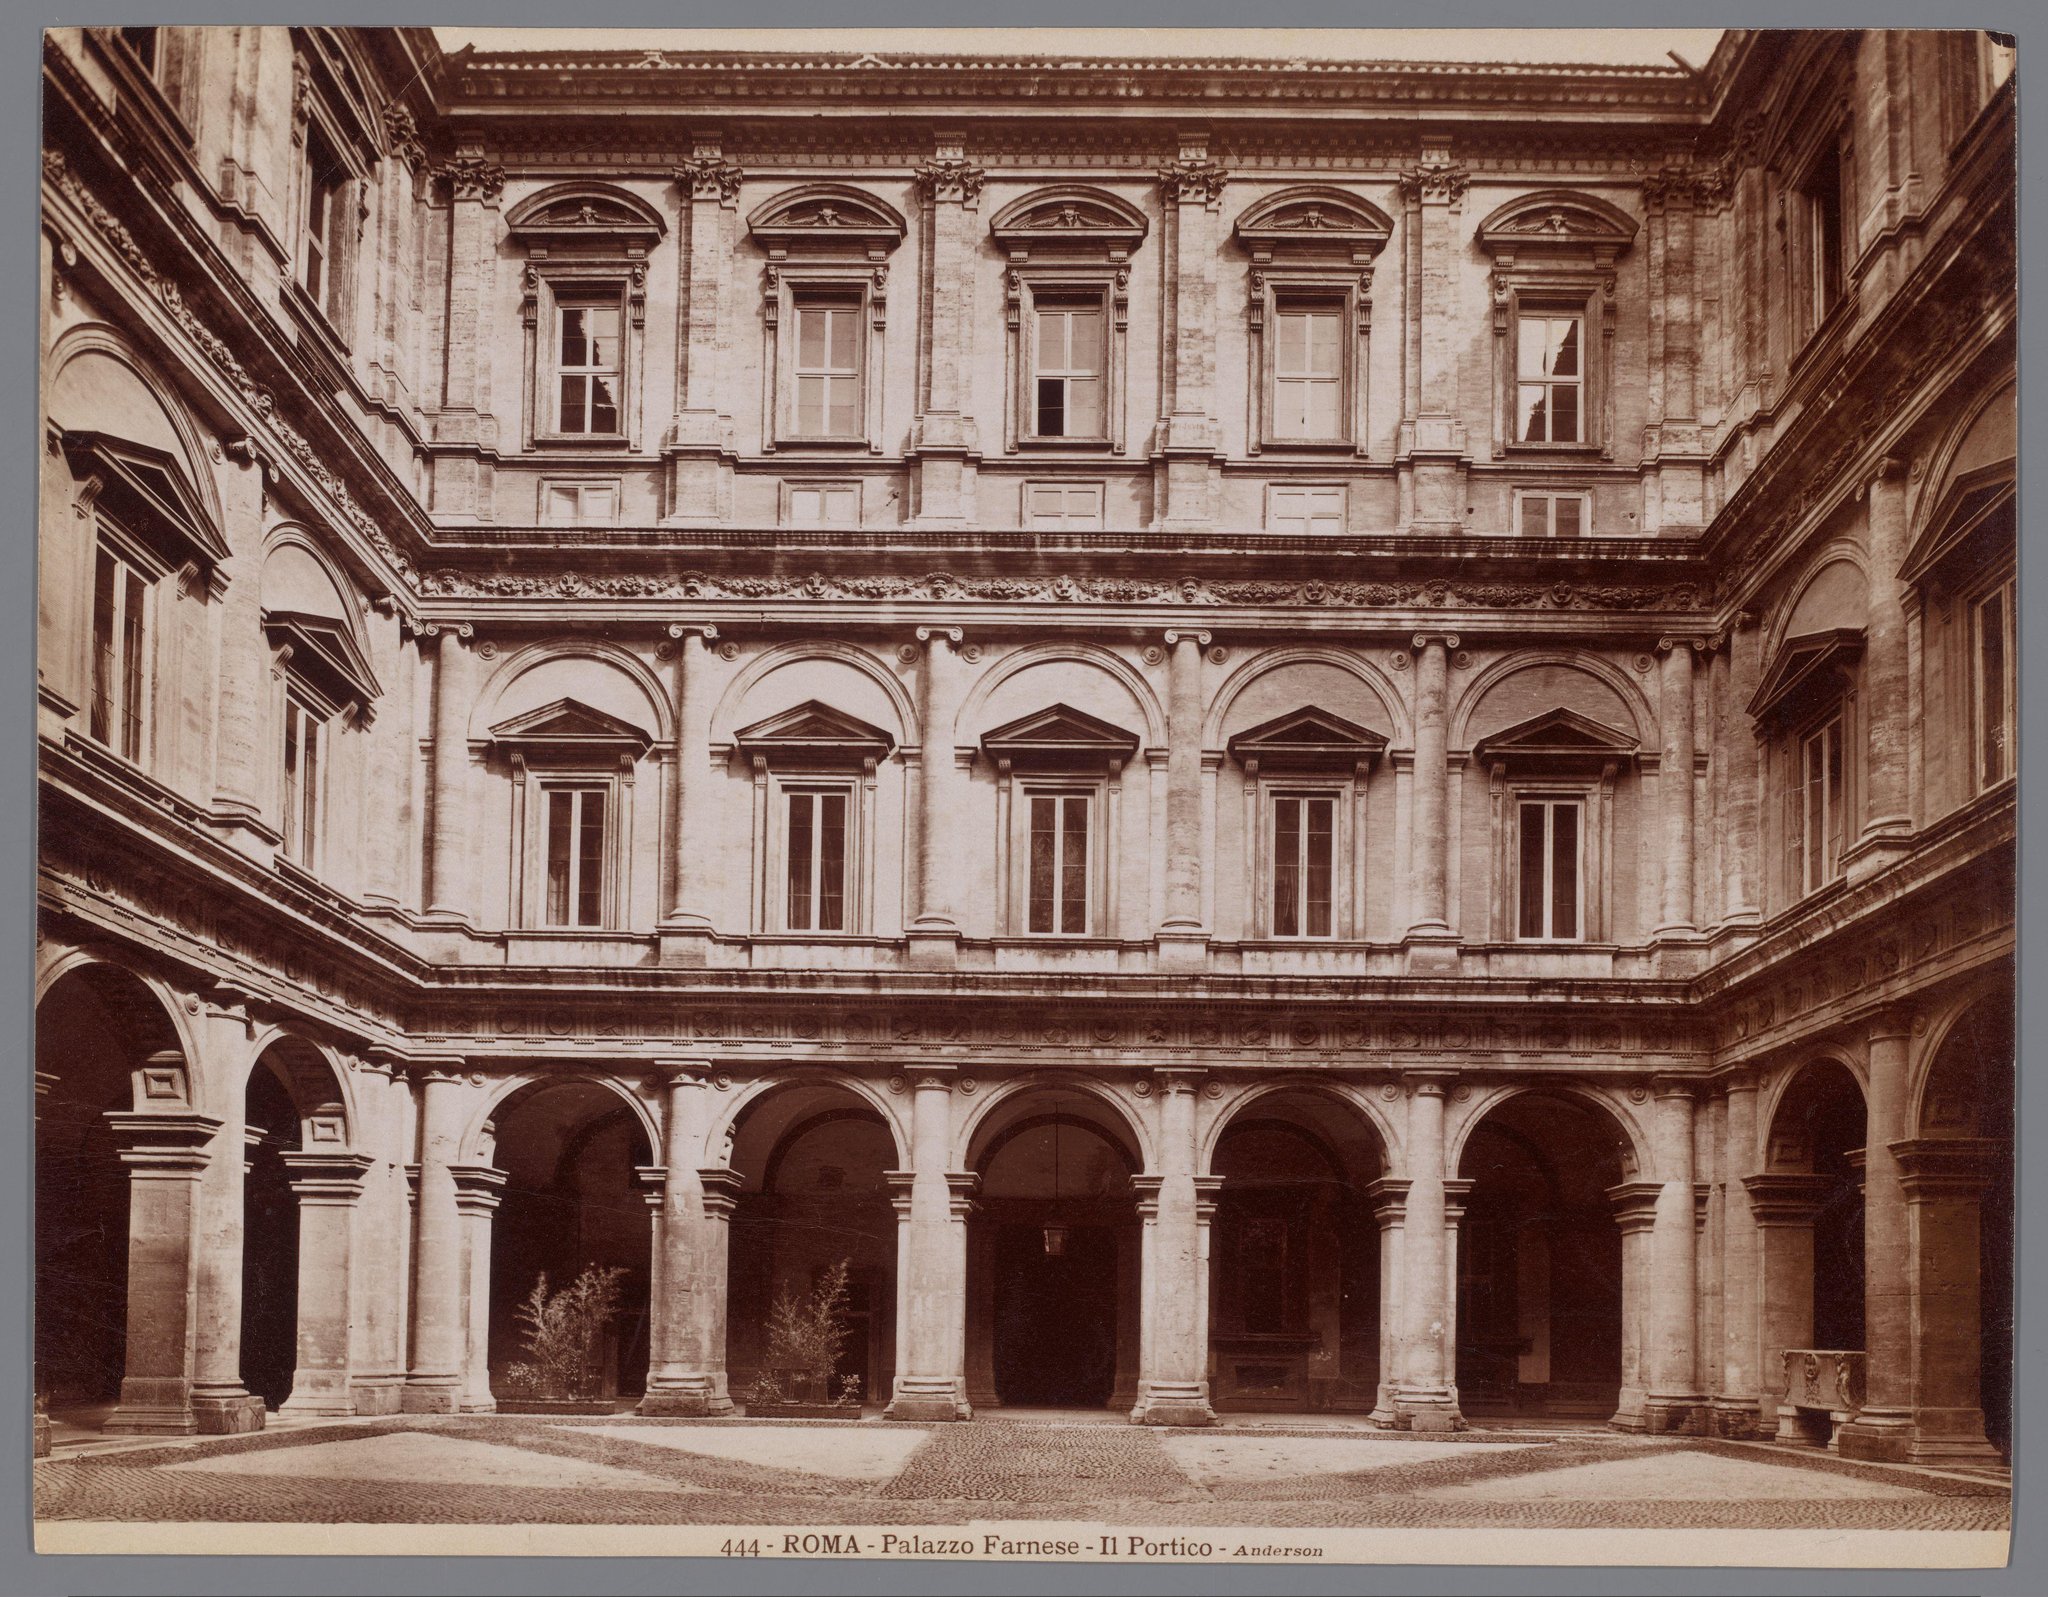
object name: photograph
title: Portico van het Palazzo Farnese, Rome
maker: james anderson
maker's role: fotograaf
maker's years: 1813-1877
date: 1870-1880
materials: photographic support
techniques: albumen print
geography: rome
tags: palace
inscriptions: inscription: ‘444 - ROMA - Palazzo Farnese - Il Portico - Anderson’, inscription: ‘James Anderson Albumen/ probably 1870's’, inscription: ‘R’, number: ‘1308’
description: Frontaal gezicht vanuit binnenplaats op het Palazzo Farnese in Rome.